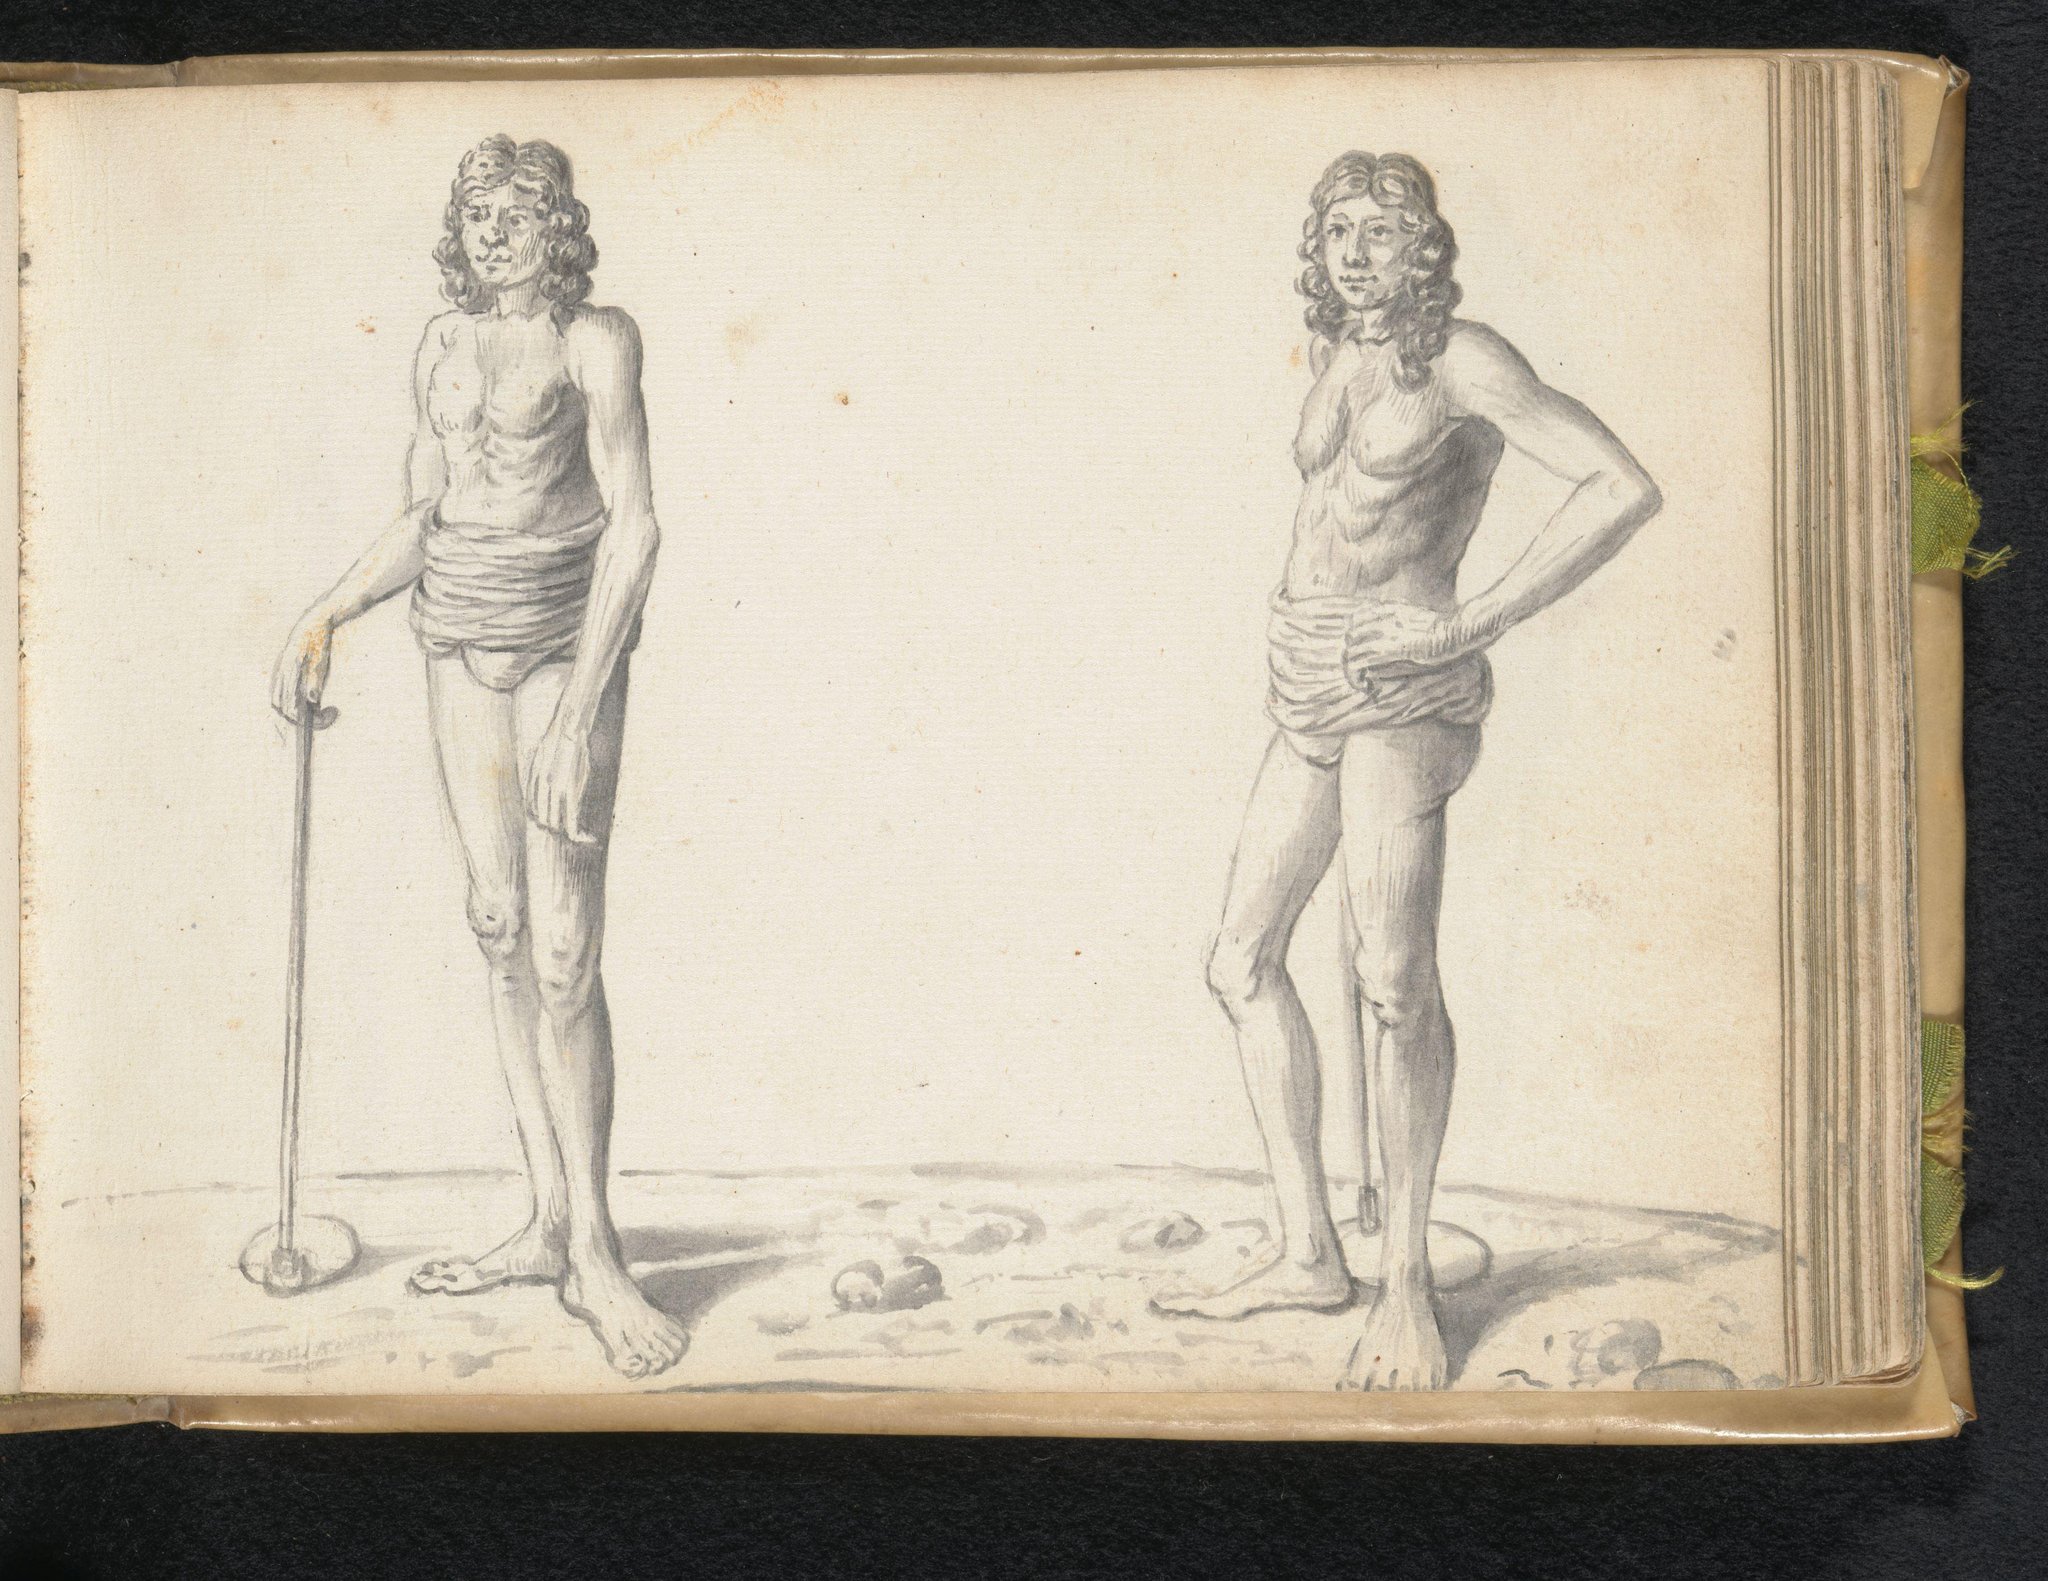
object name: sketchbook leaf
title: Two Sinhalese tillers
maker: esaias boursse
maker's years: 1631-1672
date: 1662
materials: ink, paper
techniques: brush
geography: colombo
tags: agricultural implements: hoe, asiatic races and peoples (with name), underclothes for the lower part of the body (lanket), working class, labourers, sawahs, rice paddies, sri lanka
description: Twee mannen staan buiten in een open veld. Ze staan rechtop, elk met een schoffel (udalla) aan een lange stok. Ze dragen beiden alleen een kleine lendendoek (lanket, lunket) die het kruis bedekt en de billen bloot laat. Het lange golvende haar van beide mannen hangt los over de schouders. De man links heeft de schoffel naast zich op de grond staan. Met de rechterhand houdt hij de stok vast; de linkerarm hangt ontspannen langs de zij. De man rechts – mogelijk dezelfde figuur – heeft de schoffel achter zich staan. Deze man(nen) zijn Singalese landbouwers behorend tot de Goviya-kaste. Er wordt duidelijk geposeerd voor de tekenaar met het werktuig gebruikt om de dijkjes te maken in een rijstveld. Blad 29 uit een schetsboek met 117 bladen.